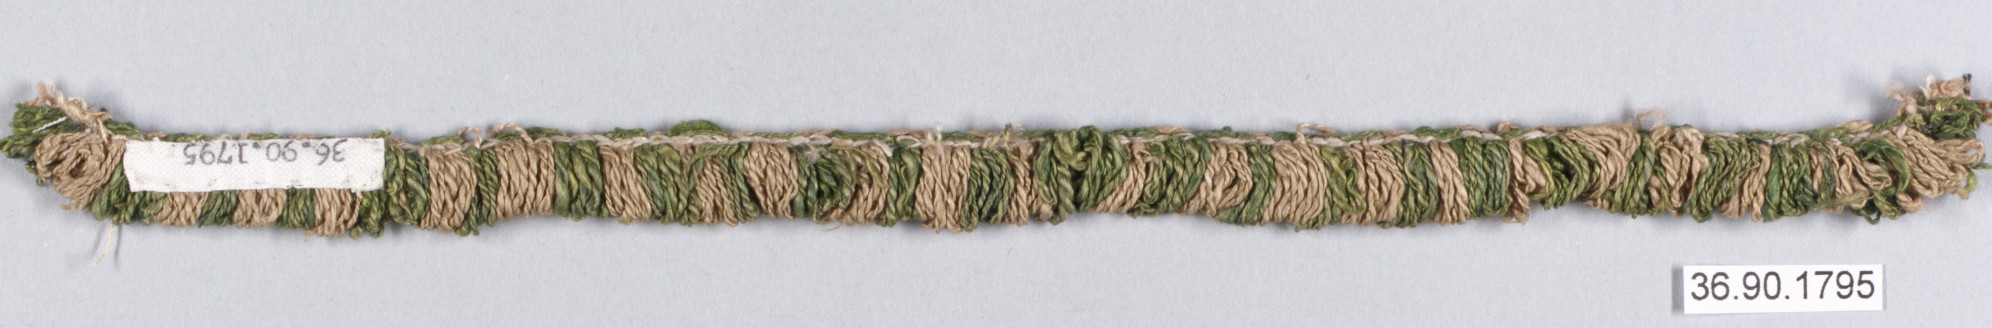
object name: fringe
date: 1701-1800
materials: silk